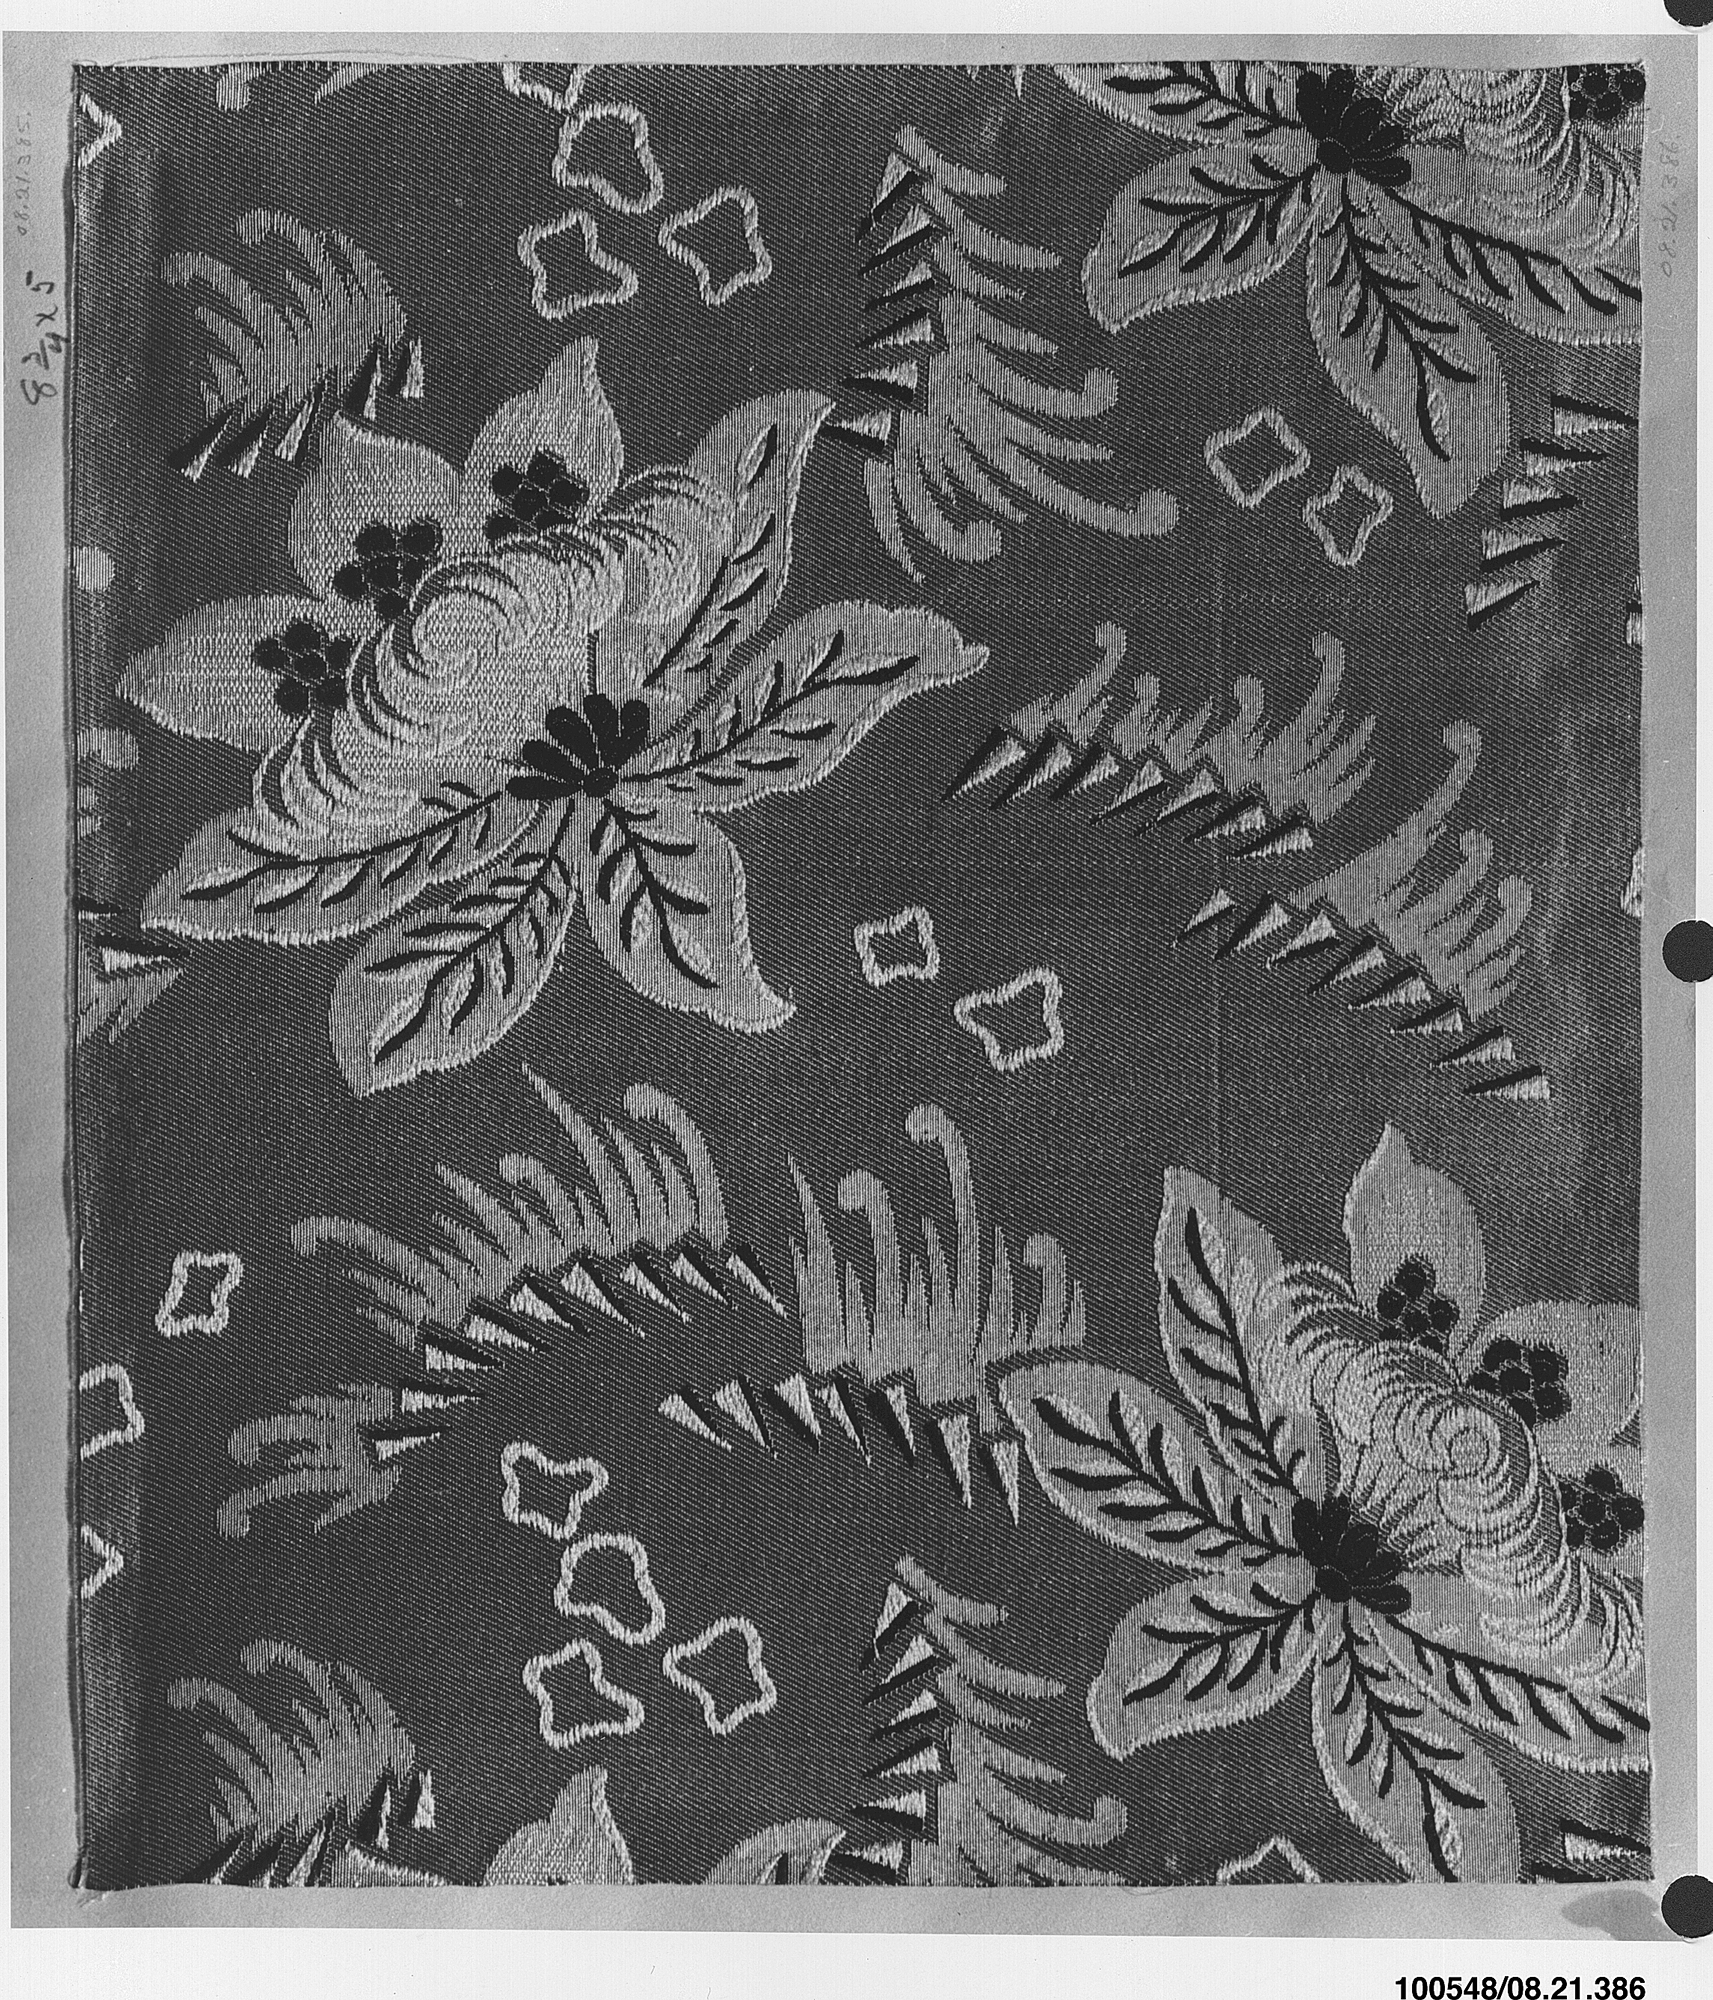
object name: textile sample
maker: Anonymous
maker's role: designer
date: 1900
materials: silk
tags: flowers